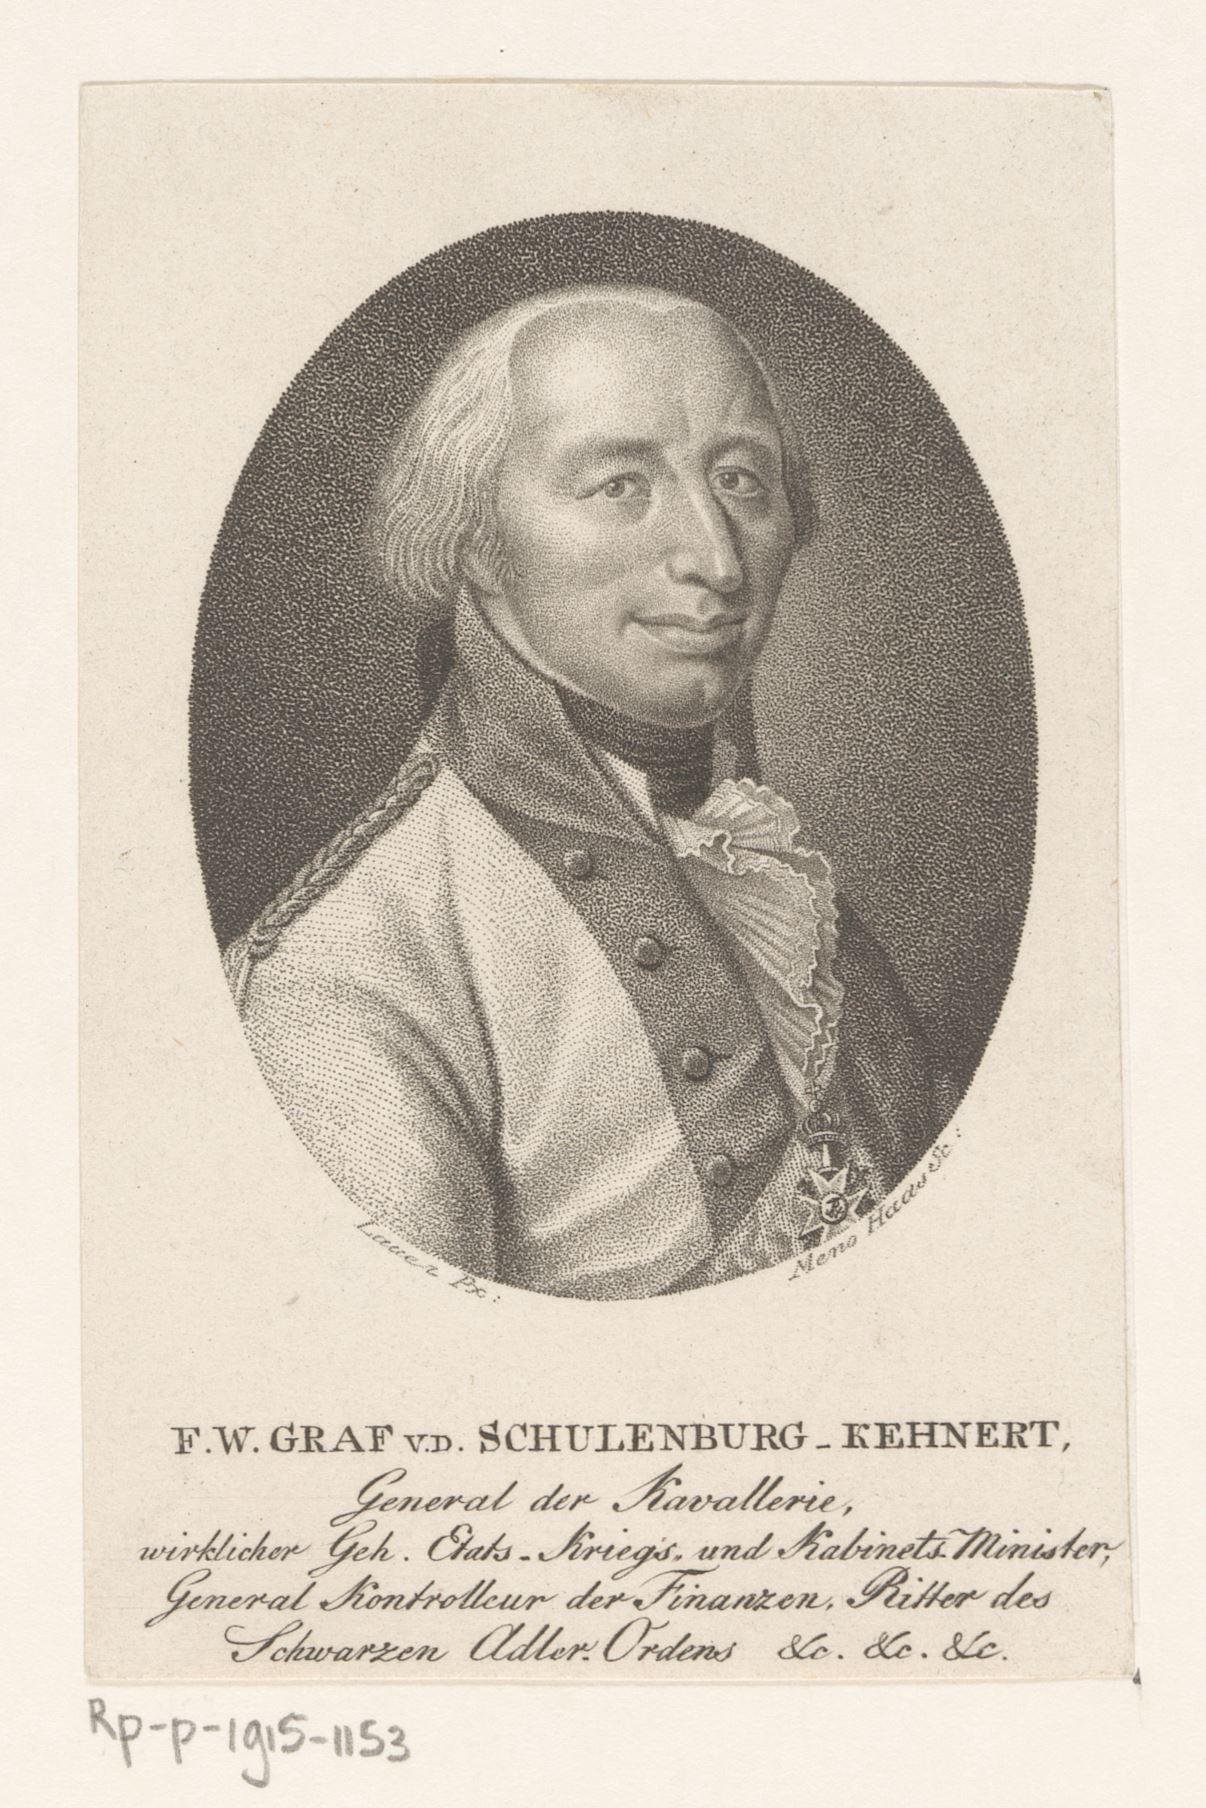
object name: print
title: Portret van Friedrich Wilhelm von der Schulenburg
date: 1762-1815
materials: paper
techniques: stippling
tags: historical persons, medals and other marks of military honour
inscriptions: collector's mark: Lugt 2228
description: Prent gebruikt voor: Jahrbücher der preußischen Monarchie unter der Regierung Friedrich Wilhelms des Dritten. Berlijn: Johann Friedrich Unger, 1800.